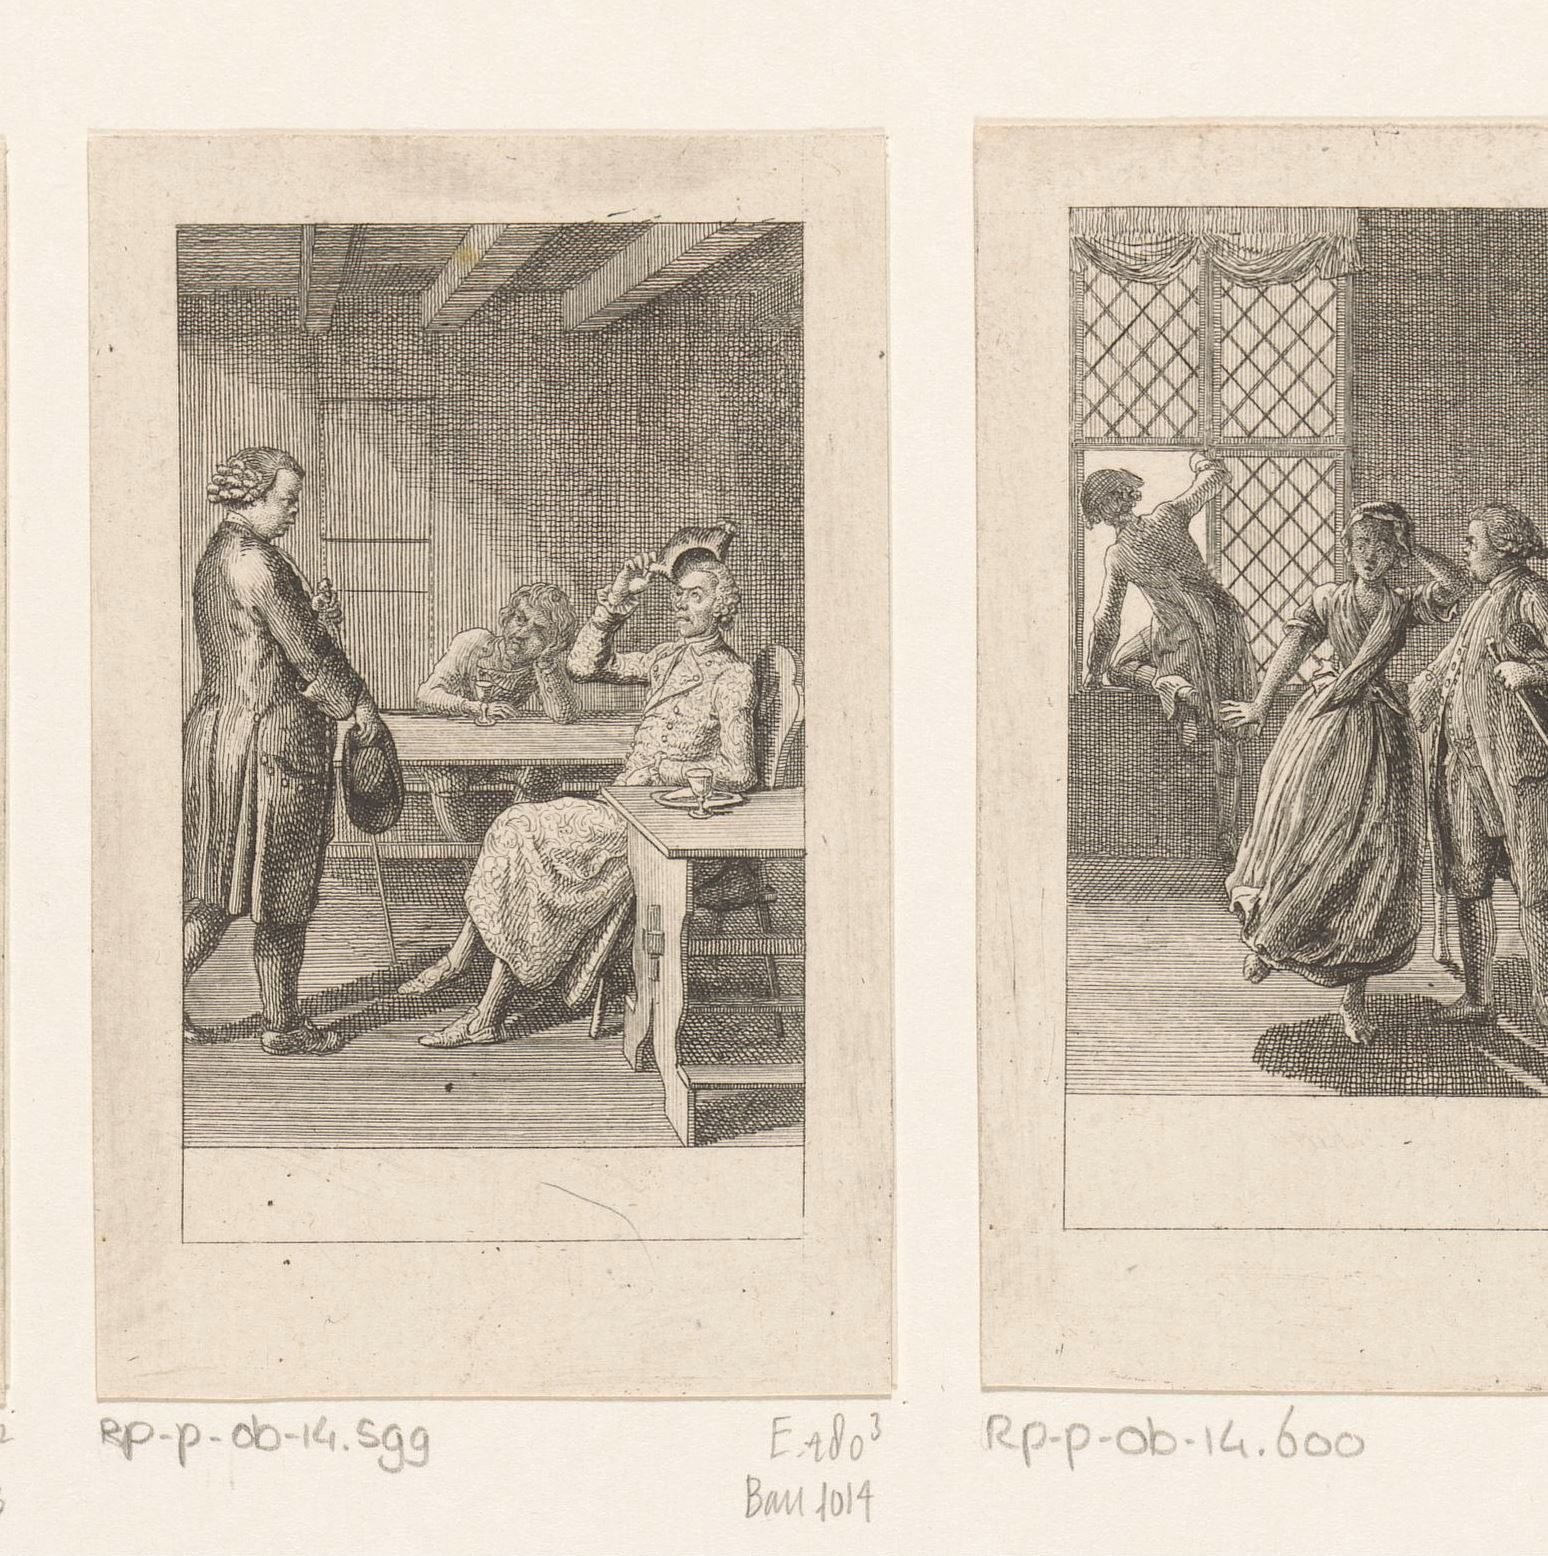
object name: print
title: Begroeting tussen de schoolmeester en Peter Fix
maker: daniel nikolaus chodowiecki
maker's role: draughtsman, print maker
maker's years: 1726-1801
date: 1783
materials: paper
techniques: etching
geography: berlin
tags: literature, baring the head, lifting one's hat, interior of the house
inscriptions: collector's mark: Lugt 2228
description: Vervaardigd voor J. G. Müller's 'Siegfried von Lindenberg'. Een latere staat gebruikt in: Goettinger Taschen Calender vom Jahr 1784. bey Joh. Chr. Dietrich. Göttingen: Georg Christoph Lichtenberg, 1784.